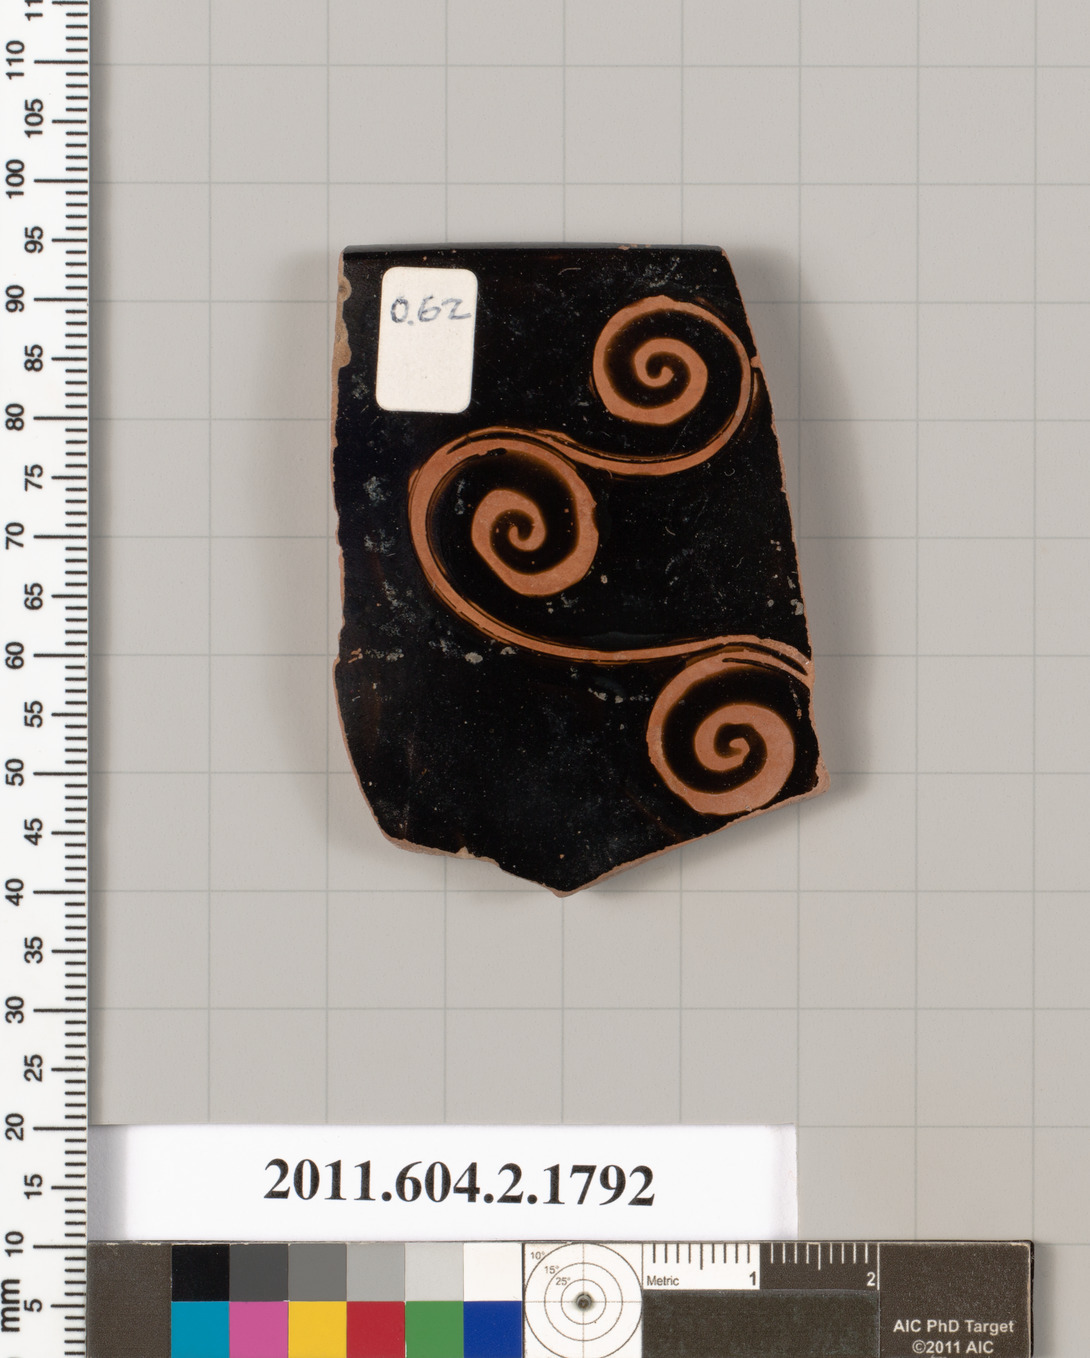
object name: skyphos fragment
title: Terracotta rim fragment of a skyphos (deep drinking cup)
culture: greek, attic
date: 475-451 BCE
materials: terracotta